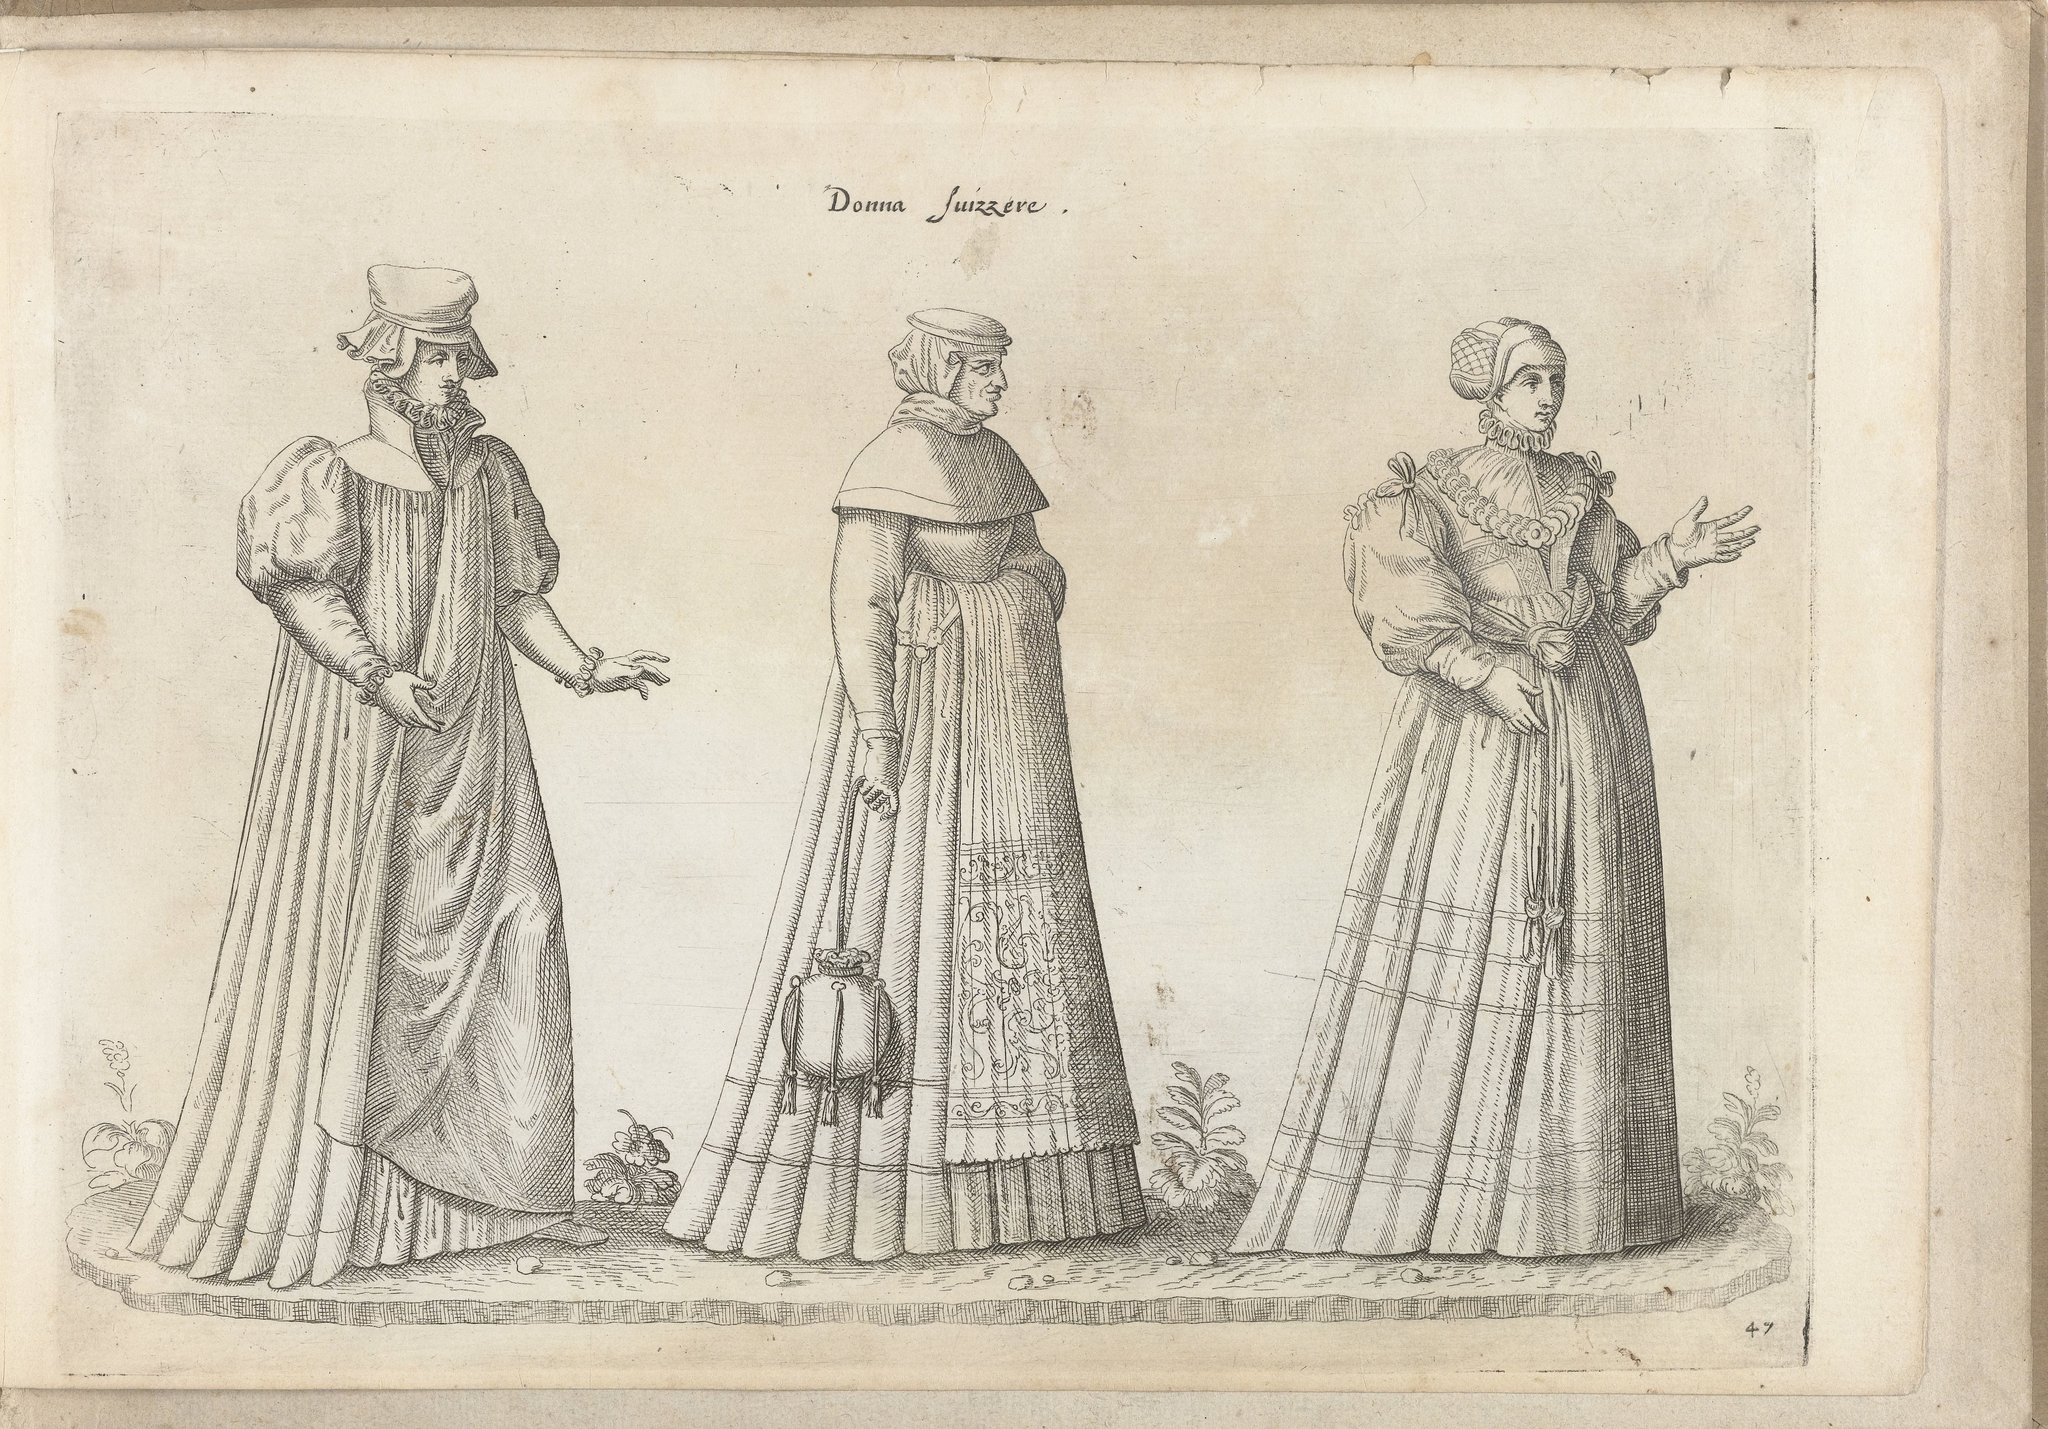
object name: costume print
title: Donna suizzere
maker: bartolomeo grassi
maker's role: publisher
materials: paper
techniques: engraving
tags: europeans (swiss) (+ costume)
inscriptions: number: ‘46’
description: Prent uit album 'Dei veri ritratti degl'habiti di tvtte le parti del mondo intagliati in rame per opra di Bartolomeo Grassi', 1585.